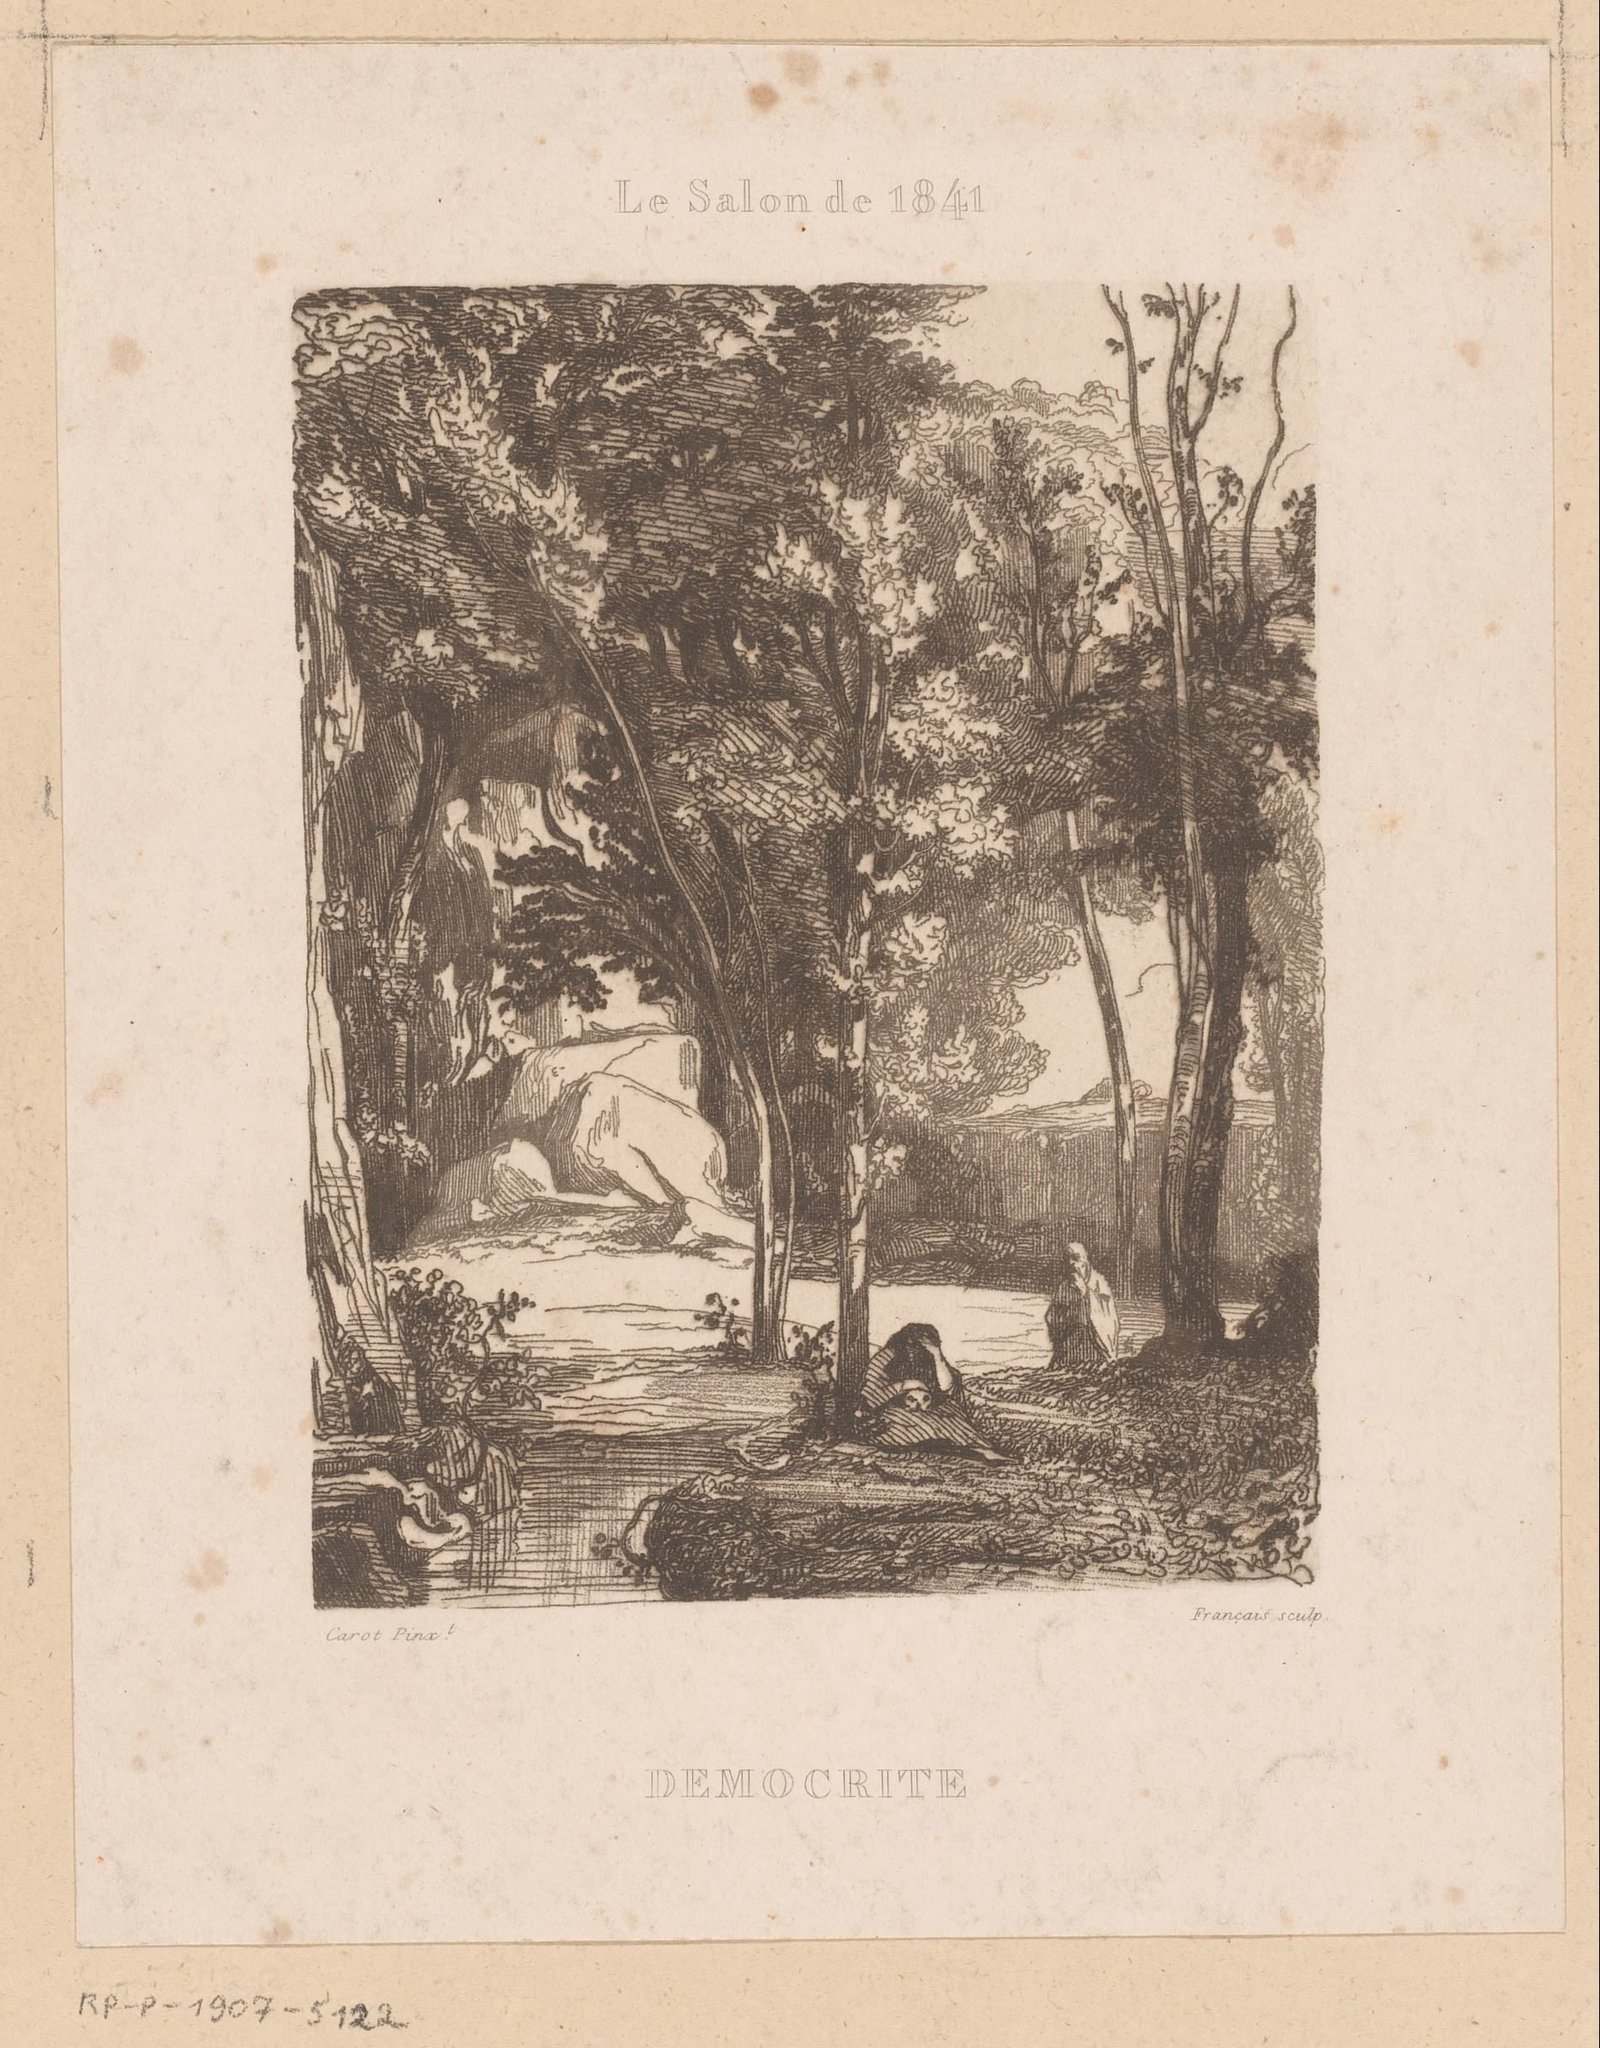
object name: print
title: Landschap met figuren aan het water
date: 1843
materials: paper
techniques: soft ground etching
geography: france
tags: water course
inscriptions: collector's mark: Lugt 2228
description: Prent uit: Les Beaux-Arts, 1843, dl. 1, p. 25.